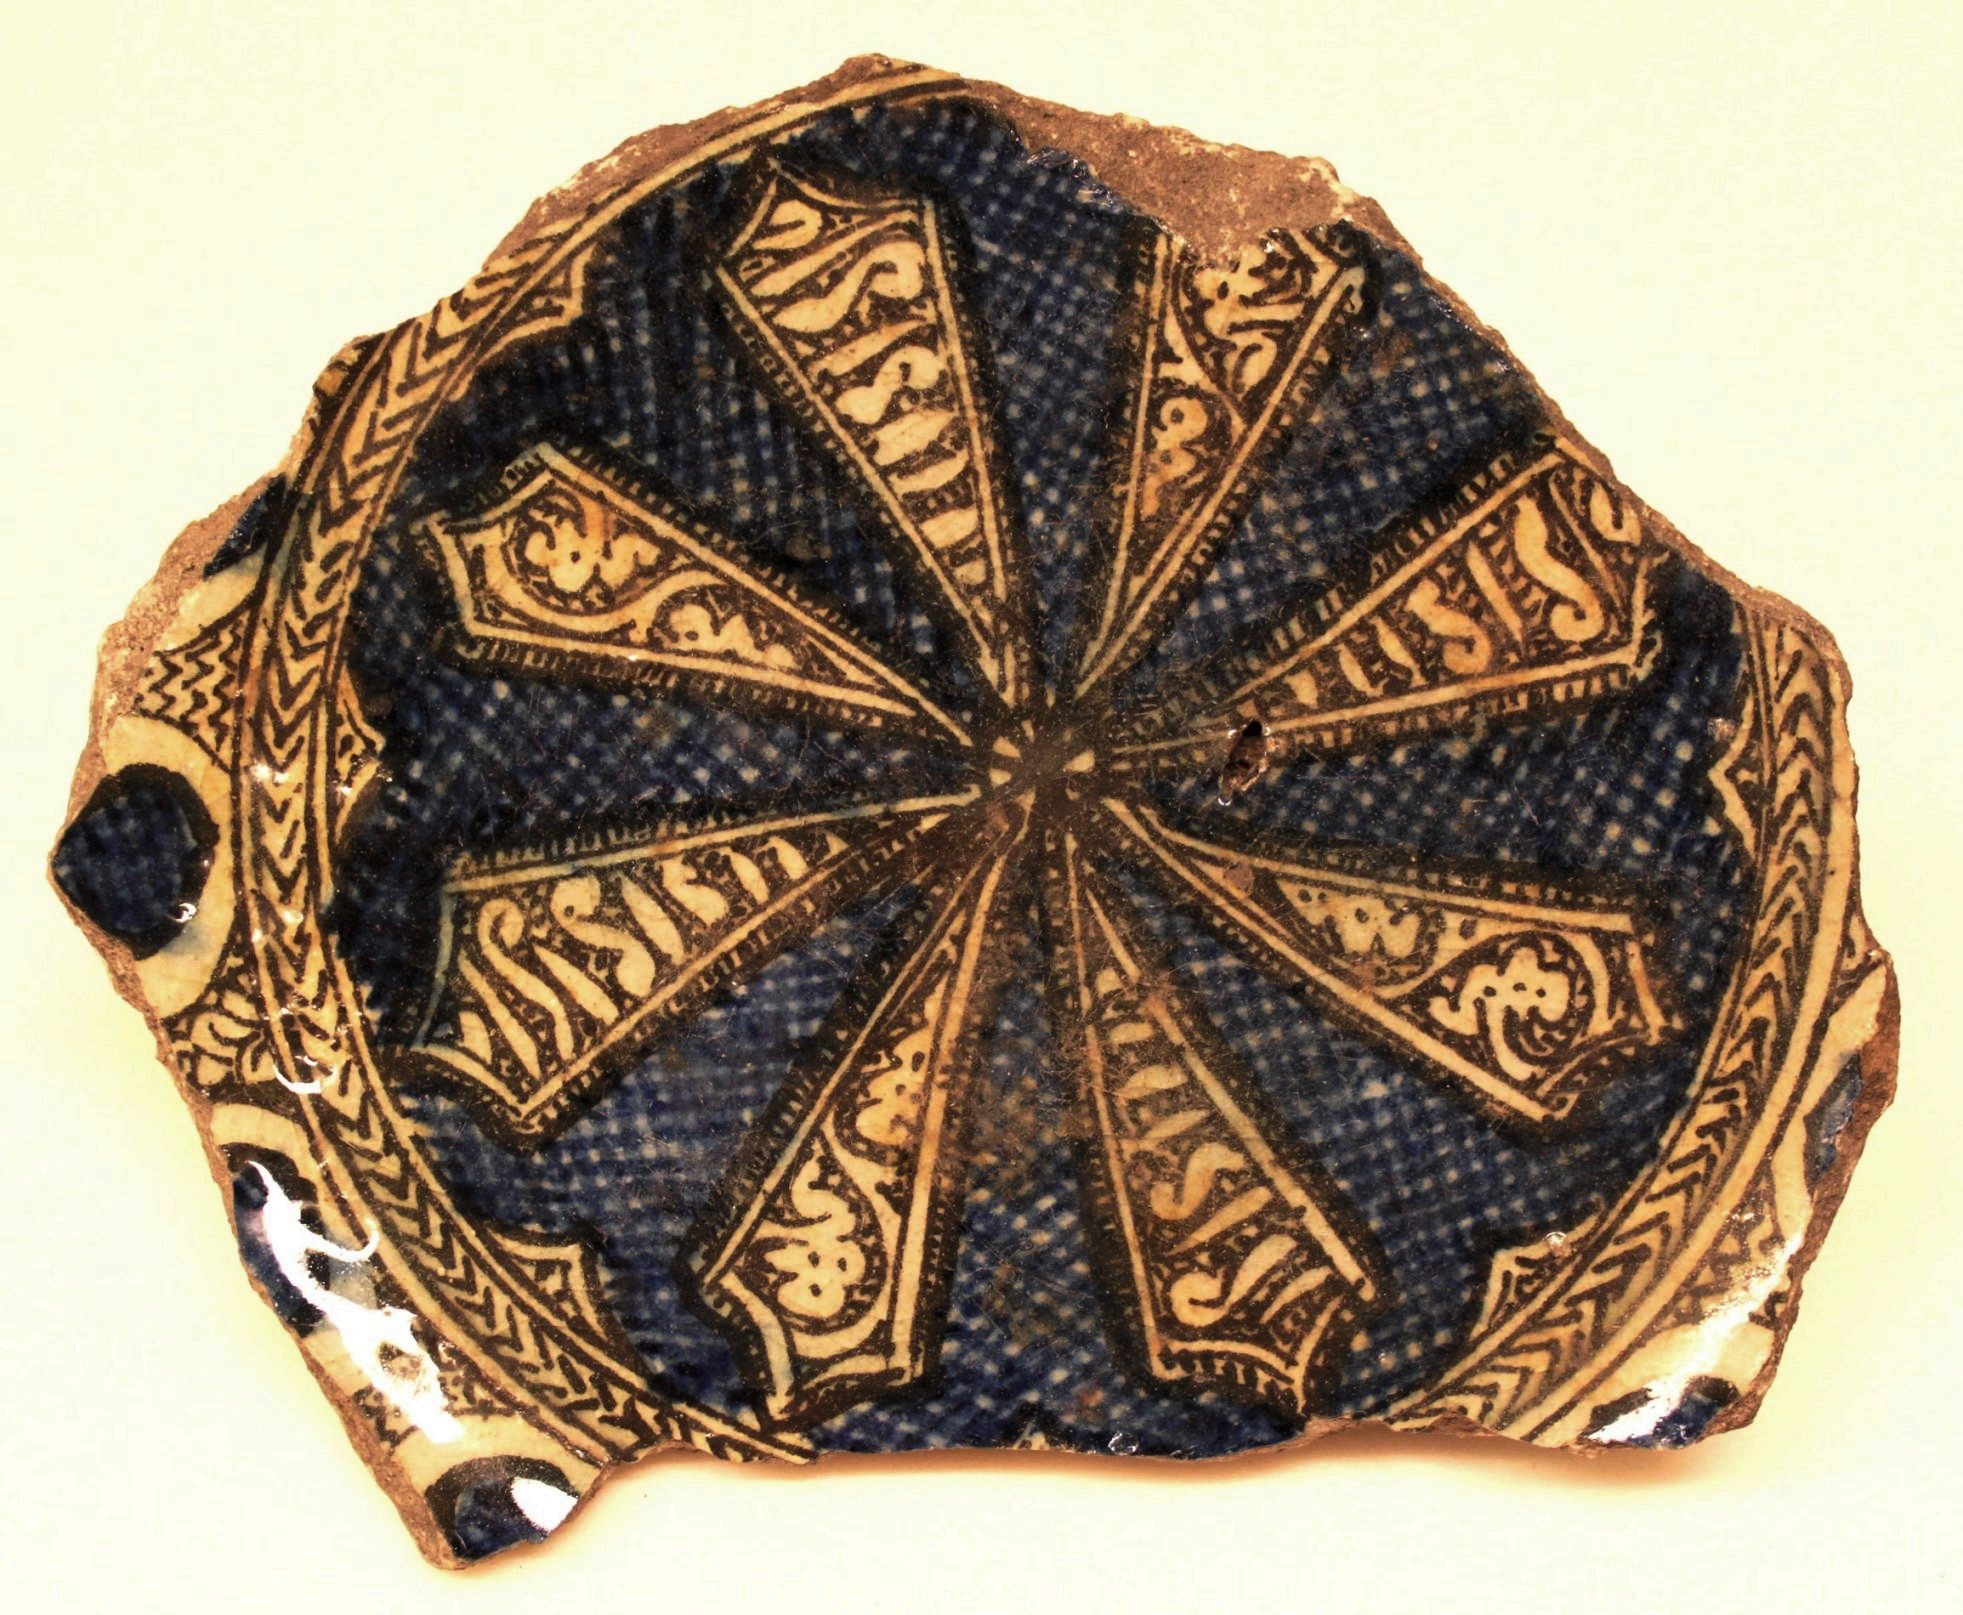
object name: fragment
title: Ceramic Fragment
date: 1301-1350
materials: glaze, stonepaste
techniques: painting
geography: syria